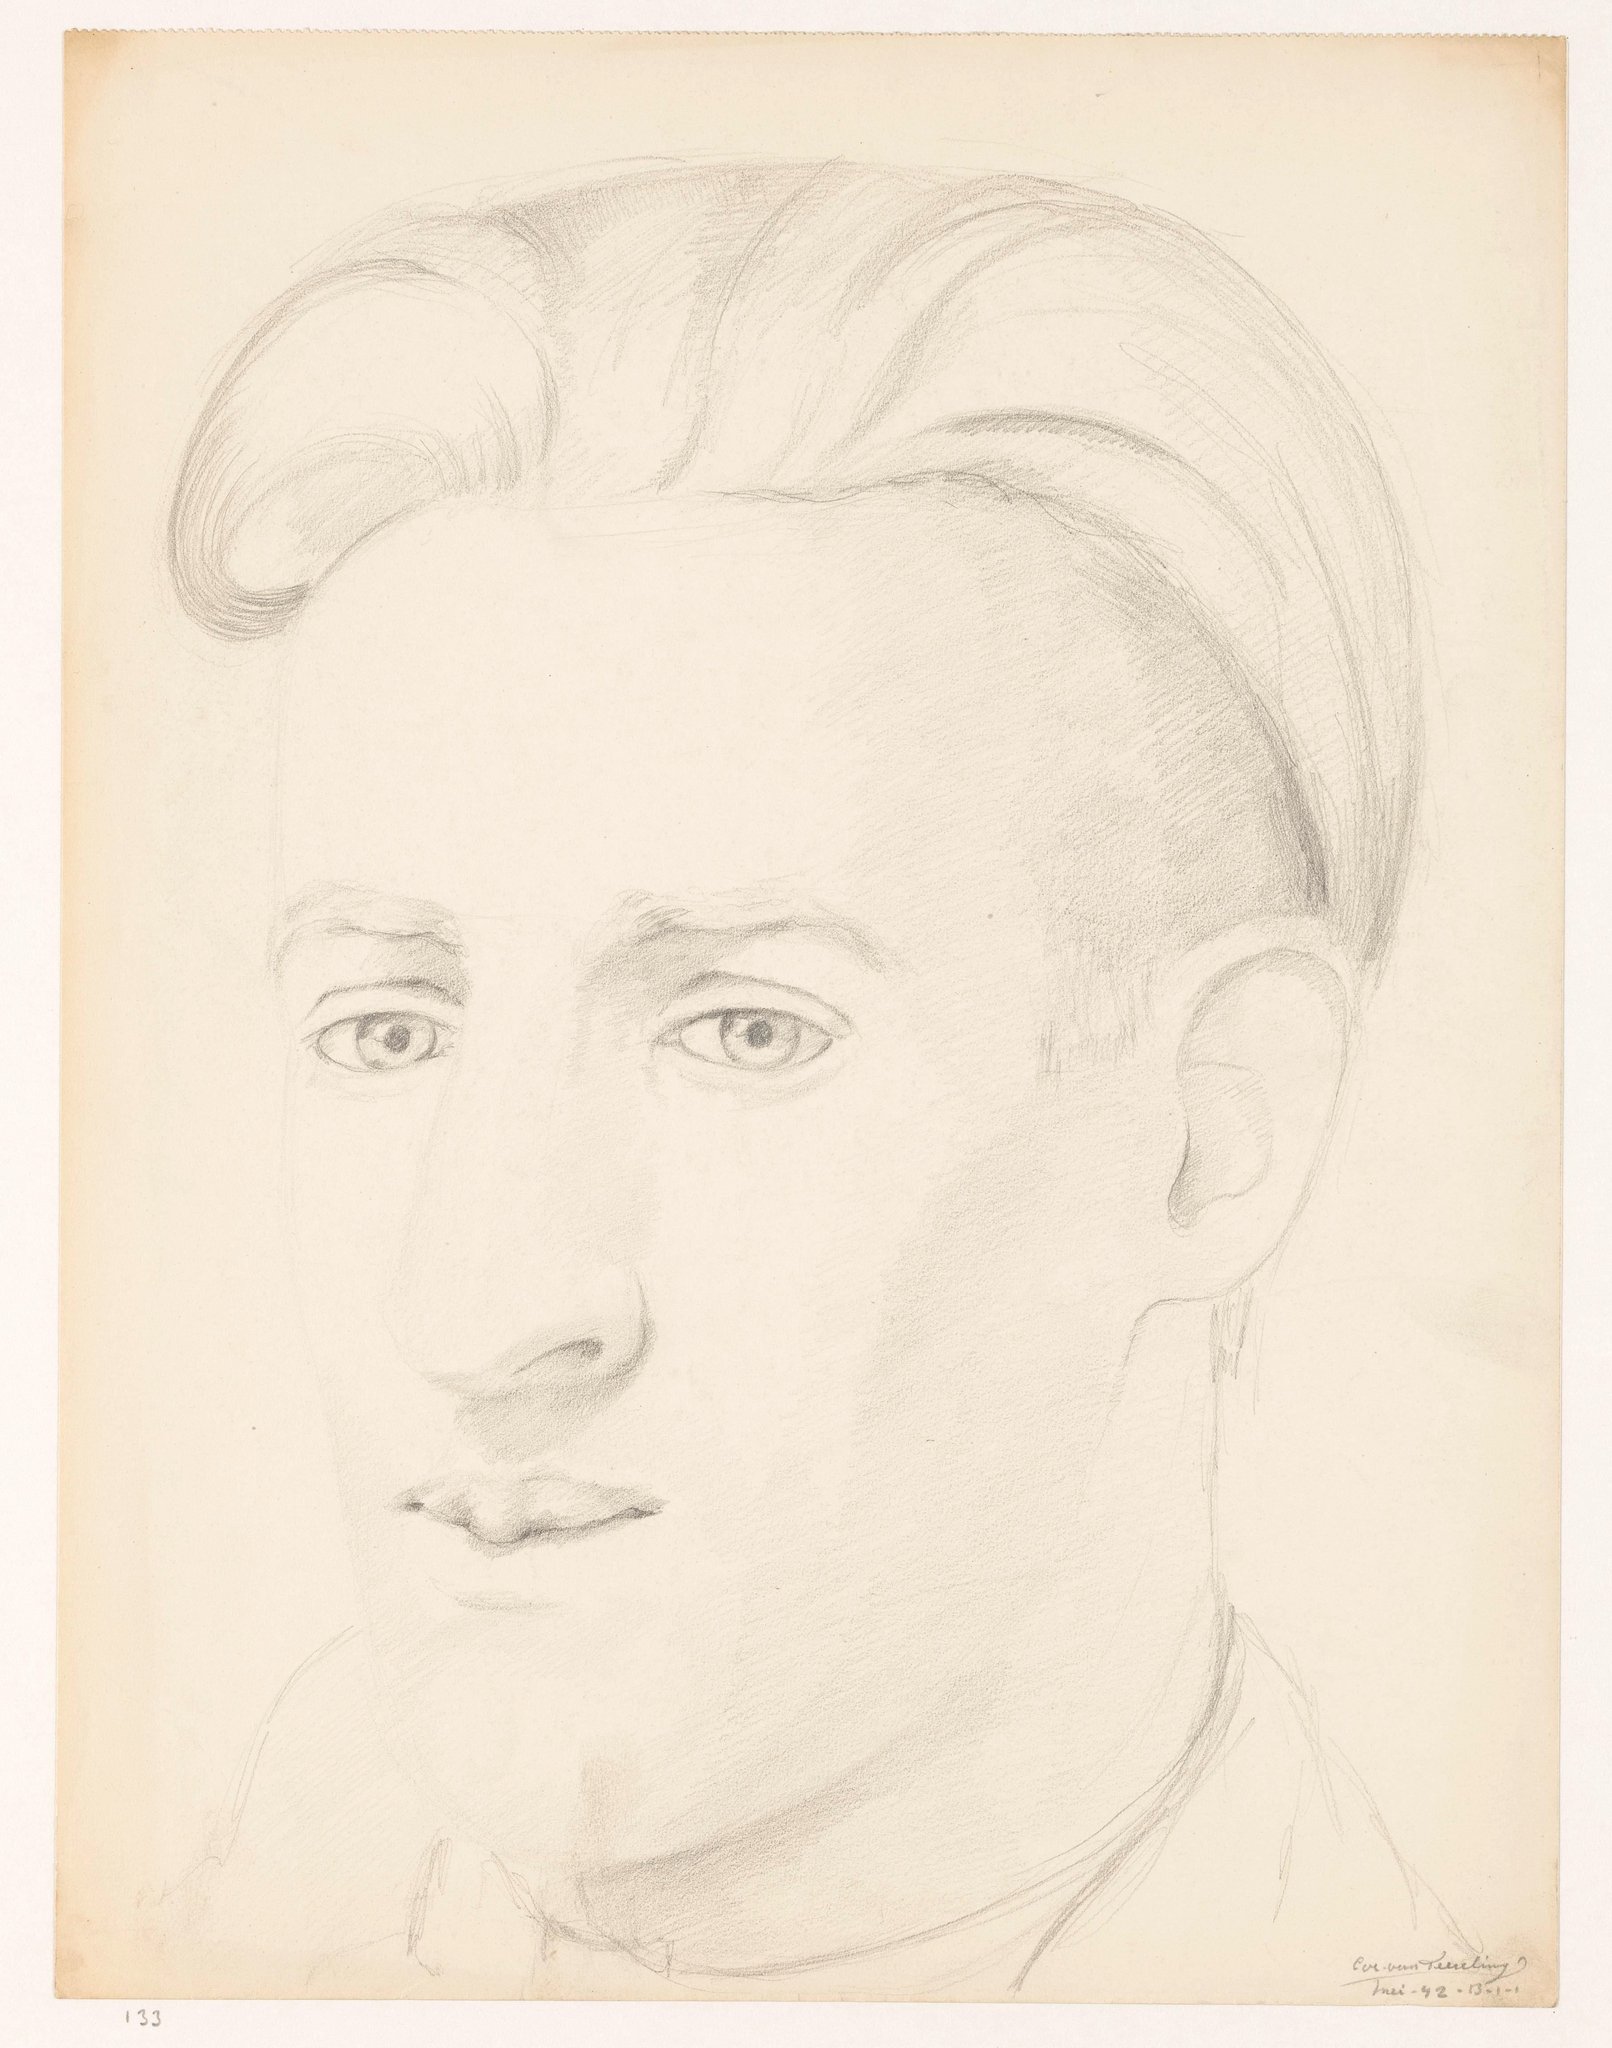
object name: drawing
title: Zelfportretten van Cor van Teeseling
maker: cor van teeseling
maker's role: draughtsman, sculptor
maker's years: 1915-1942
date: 1905-1942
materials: paper, pencil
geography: weteringschans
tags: amsterdam, draughtsman, sculptor, cor van teeseling, historical persons, prisoner in cell or locked place, portrait, self-portrait of draughtsman, netherlands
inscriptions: signature and date: ‘Cor van Teeseling / mei-42 B-1-1’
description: Zelfportret van Cor van Teeseling: B-1-1, mei 1942. Cor van Teeseling driekwart afgebeeld, zijn hoofd naar links gewend.